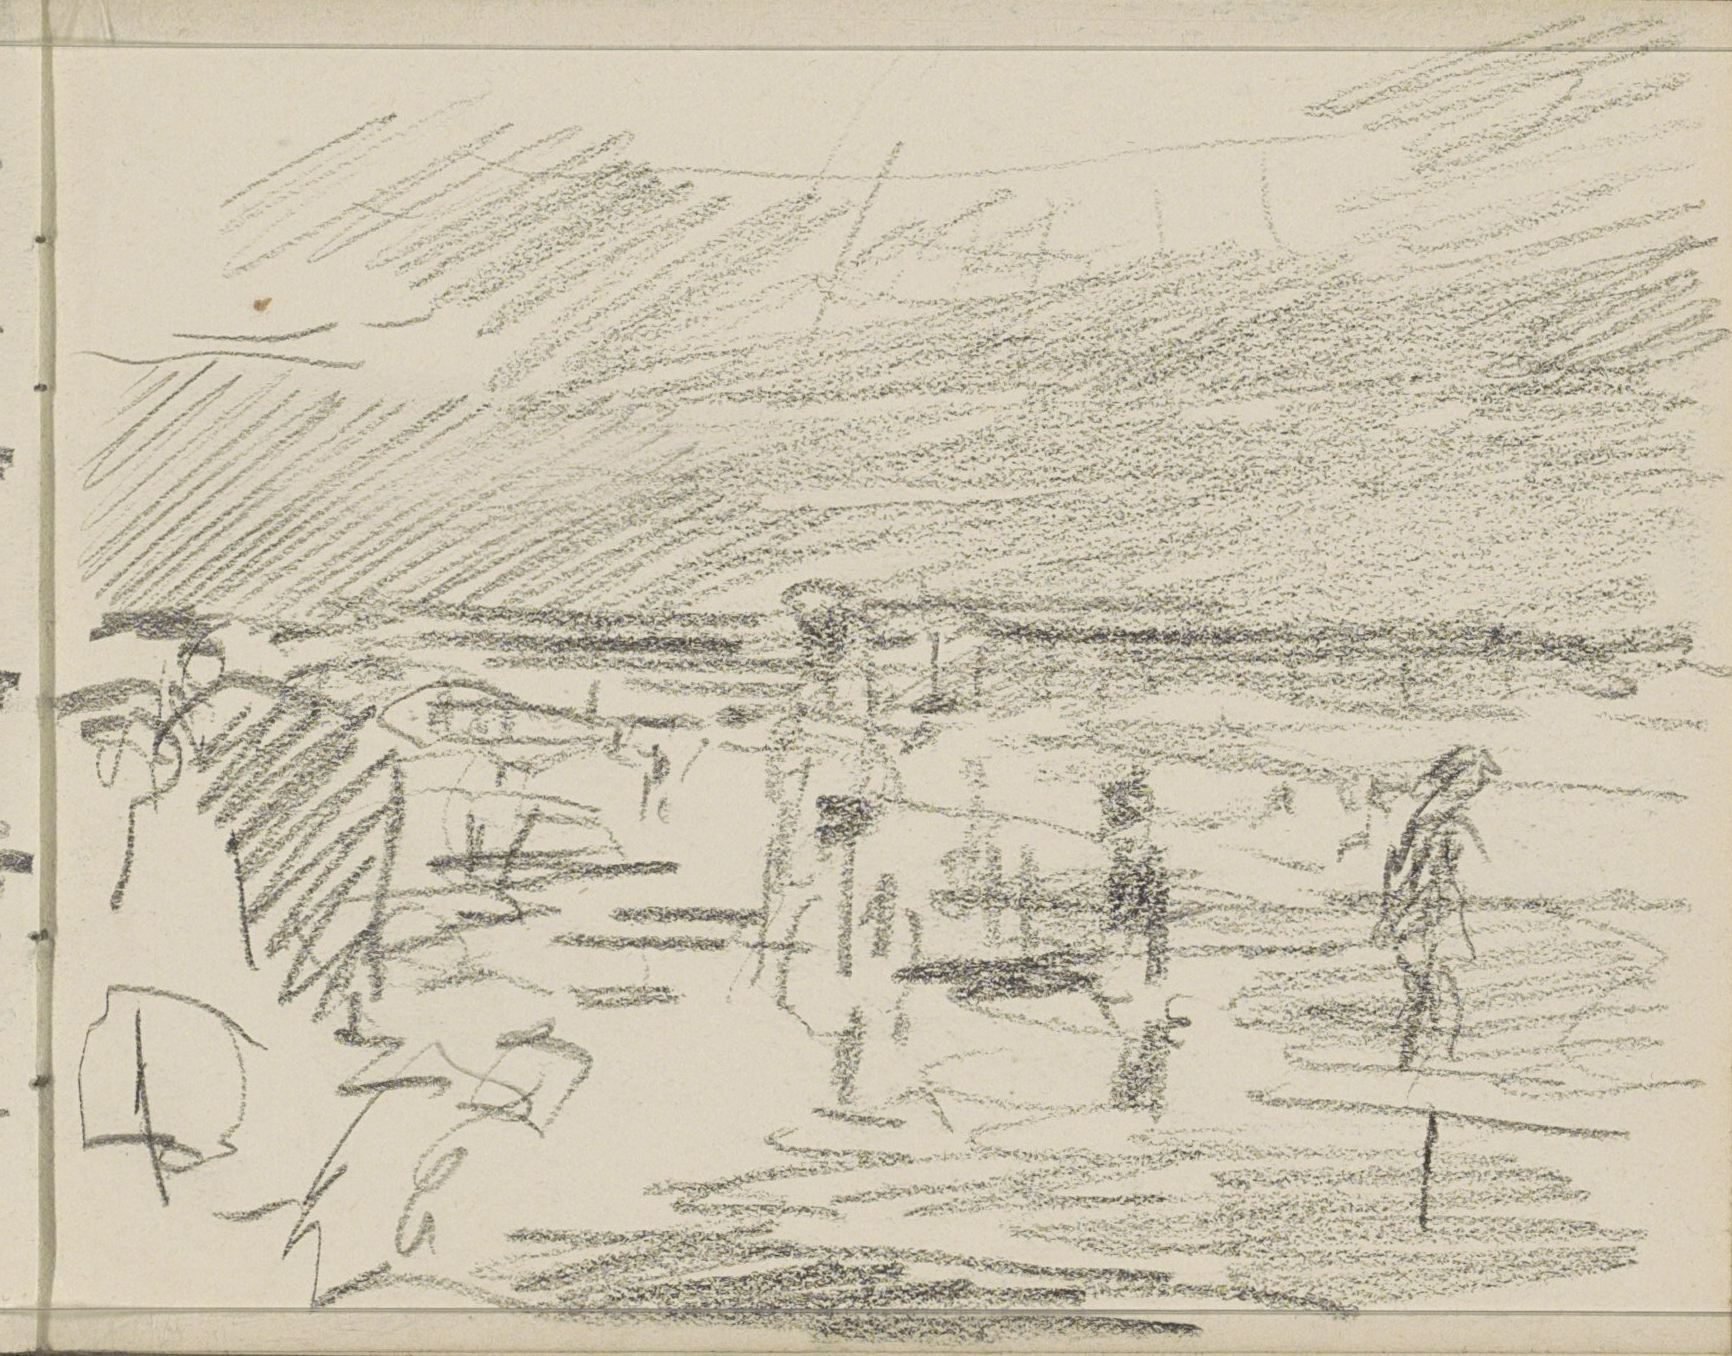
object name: sketchbook leaf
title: Figuren in de branding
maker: johan antonie de jonge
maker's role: draughtsman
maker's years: 1864-1927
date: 1881-1927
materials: chalk, paper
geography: south holland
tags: in or beside the water (on the beach)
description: Figuren in de branding. Blad 6 uit een schetsboek met 29 bladen.